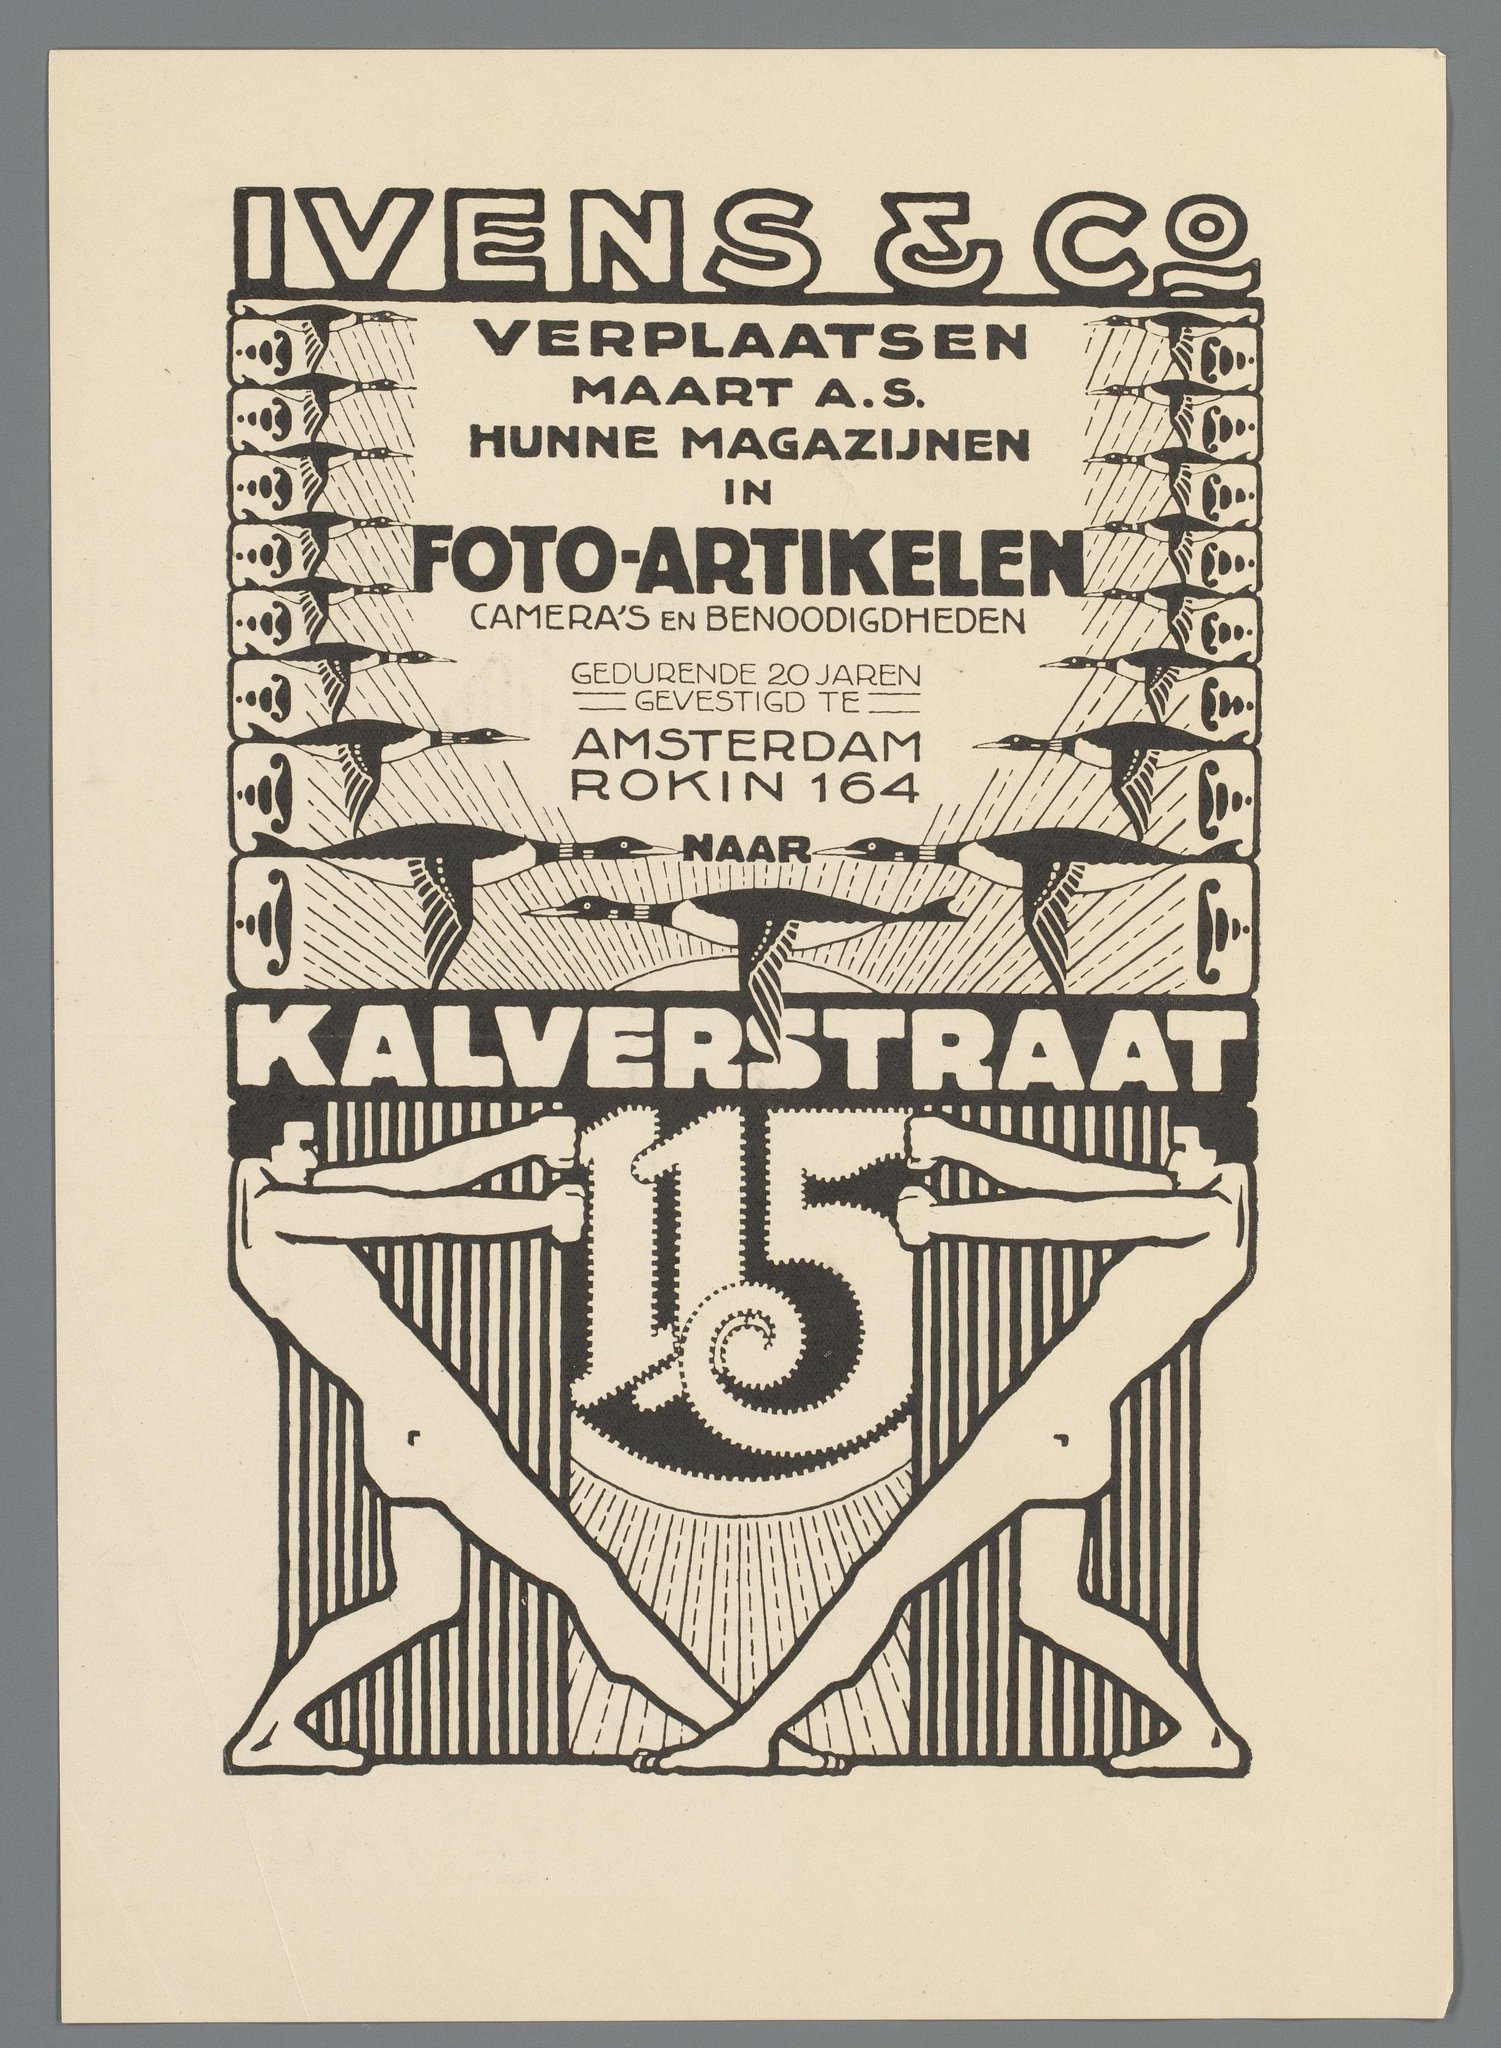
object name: photomechanical print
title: Verhuisaankondiging van de winkel van Ivens & Co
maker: Anonymous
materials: paper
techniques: printing block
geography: amsterdam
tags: moving (house), birds, man (showing himself) undressed, quasi-nude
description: Bovenaan twee naakte mannenfiguren die roldeuren open trekken met daarachter het (huis)nummer '115'. Daarboven twee rijen van vogels rond de tekst: 'Ivens & Co verplaatsen maart a.s. hunne magazijnen in foto-artikelen camera's en benoodigdheden gedurende 20 jaren gevestigd te Amsterdam Rokin 164 naar Kalverstraat 115'.